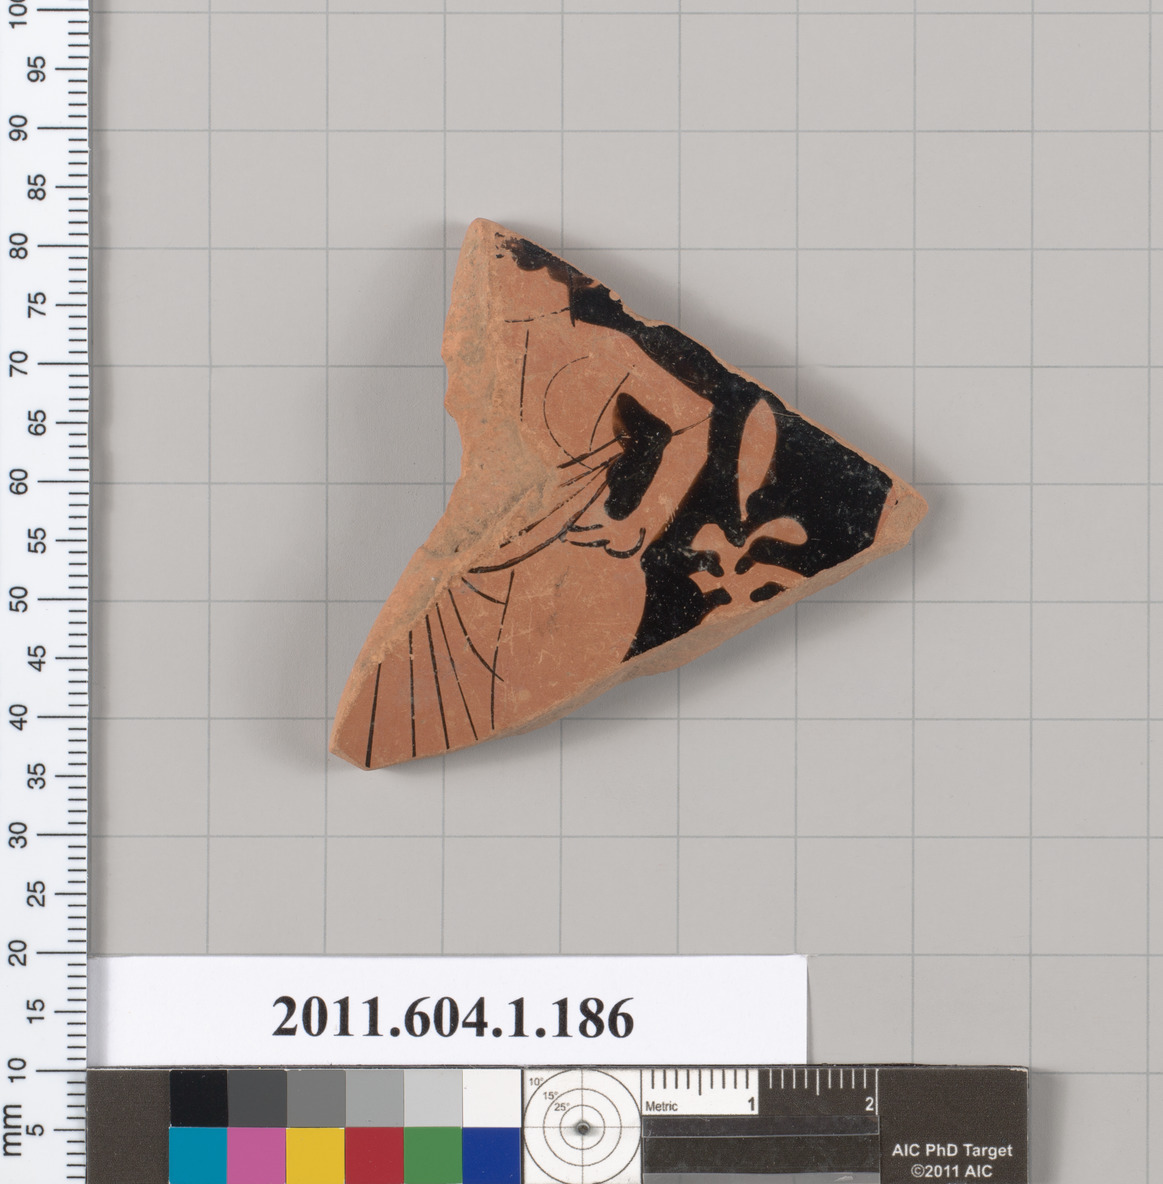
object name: kylix fragment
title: Terracotta fragment of a kylix (drinking cup)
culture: greek, attic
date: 475-451 BCE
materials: terracotta